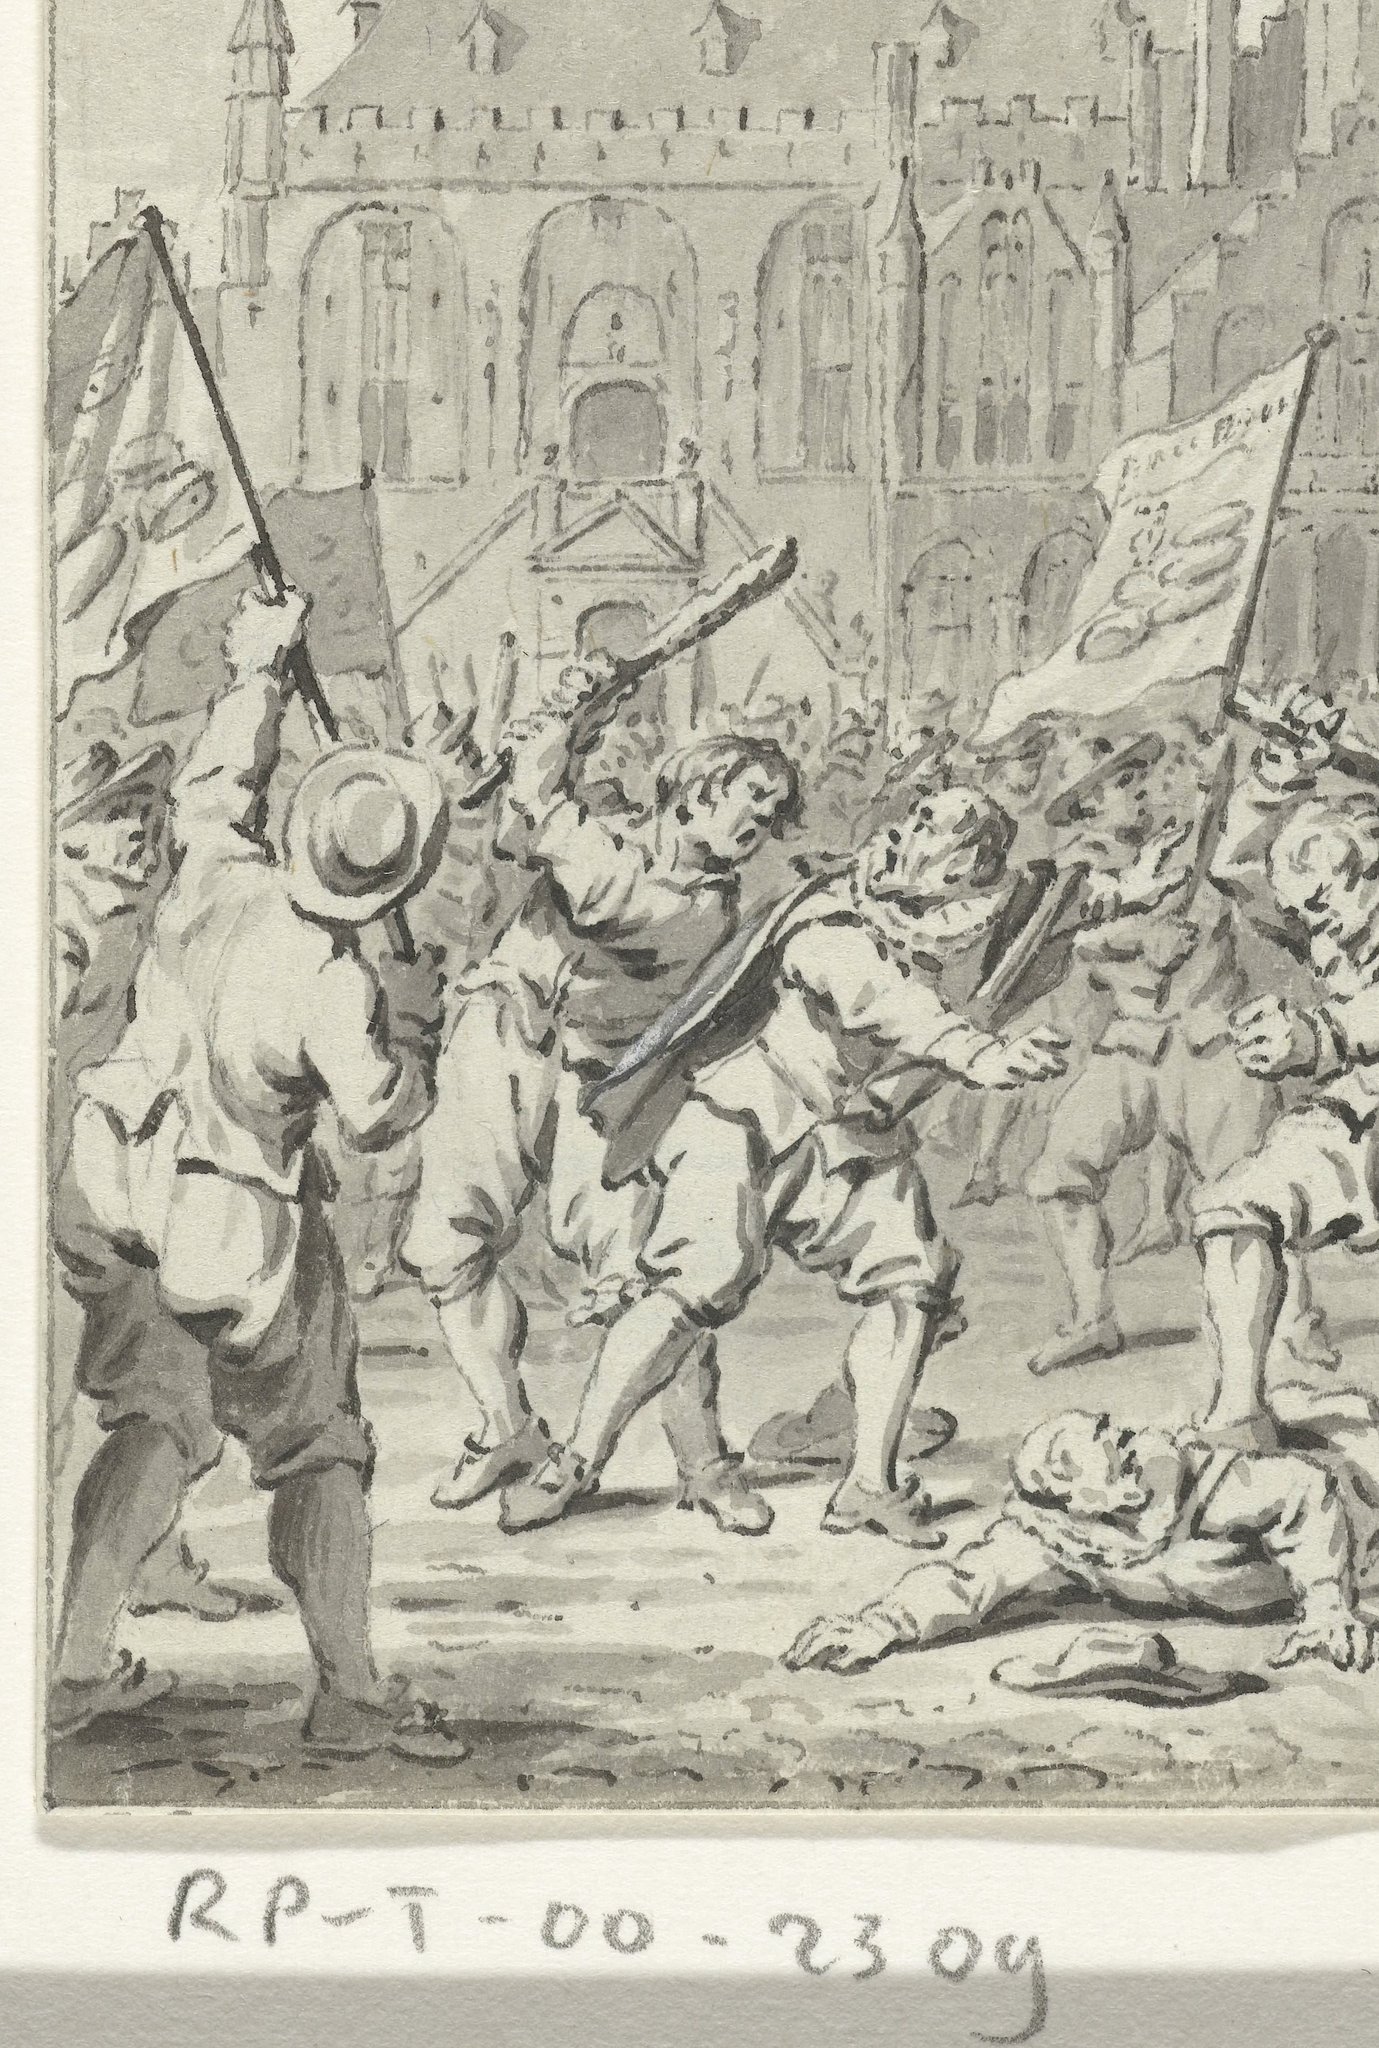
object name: history print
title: Opstand van het Kaas- en Broodvolk en moord op Claes van Ruyven te Haarlem, 1492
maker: jacobus buys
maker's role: draughtsman, print maker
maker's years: 1724-1801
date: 1778-1795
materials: ink, paper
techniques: brush, pen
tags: historical persons, murder, violent death, being killed; being mishandled and maltreated; seeking death, street-fights, riots, historical events and situations, haarlem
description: Ontwerptekening voor illustratie in: J. Fokke, Geschiedenissen der Vereenigde Nederlanden voor de vaderlandsche jeugd, Johannes Allart, Amsterdam 1783-1795, 25 delen, dl. III, pl. II.